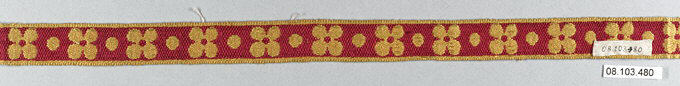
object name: galloon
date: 1801-1900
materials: silk